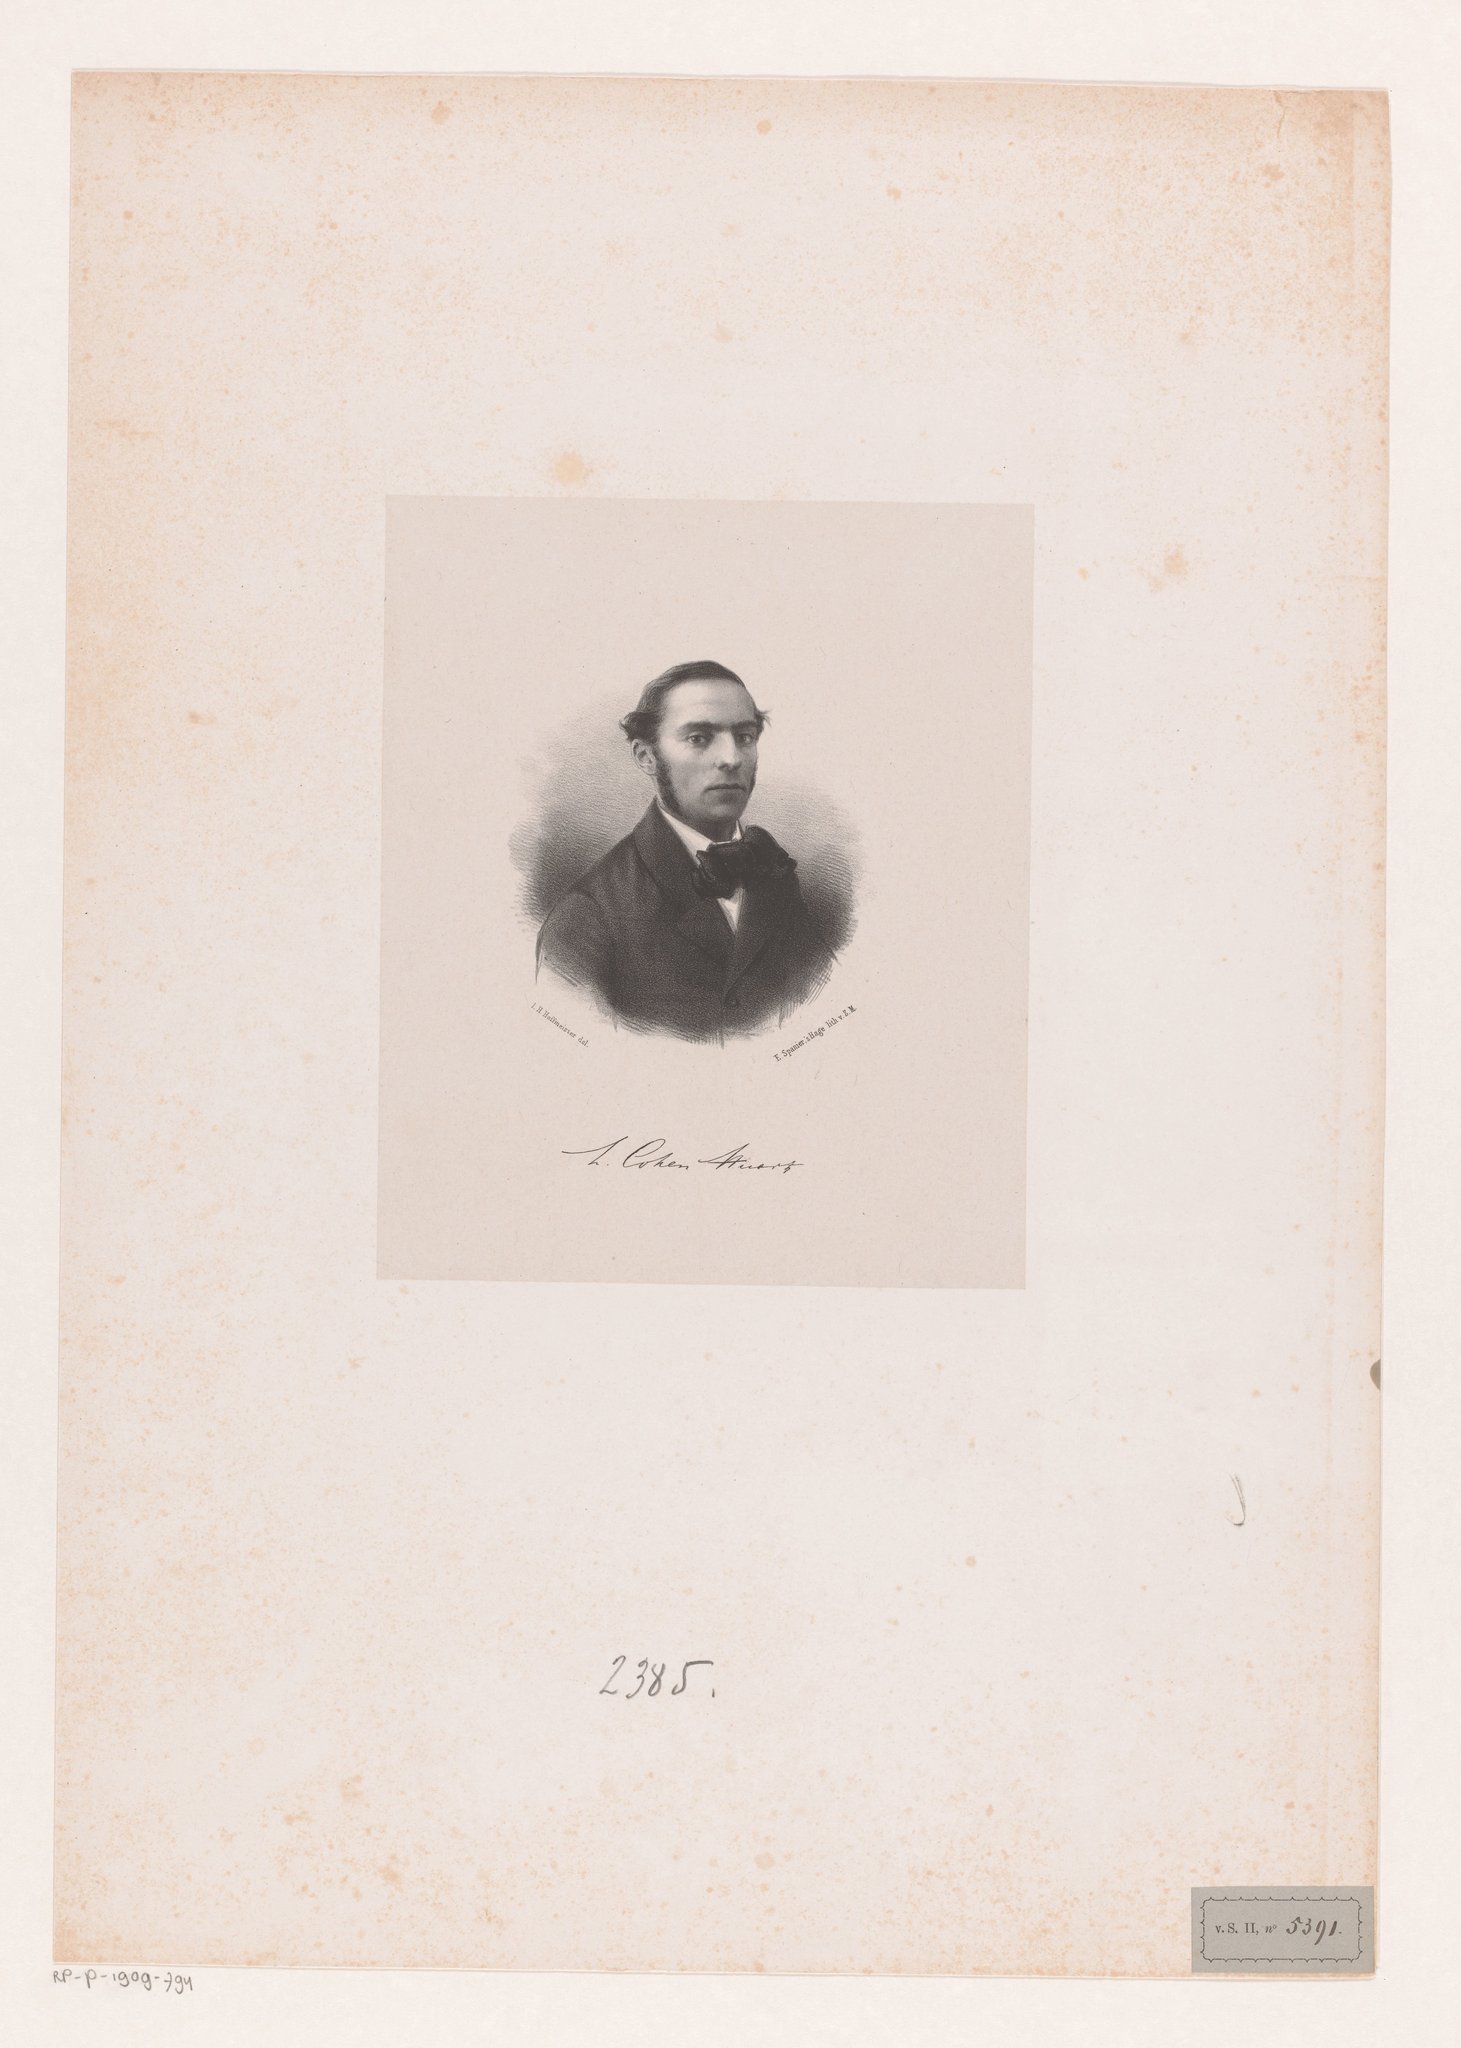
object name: print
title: Portret van Lewis Cohen Stuart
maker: johan hendrik hoffmeister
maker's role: print maker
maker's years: 1823-1904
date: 1851-1883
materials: paper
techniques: lithograph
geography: the hague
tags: the hague, delft, historical persons (+ (full) bust portrait)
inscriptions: collector's mark: Lugt 2228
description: Onder het portret de signatuur van de geportretteerde.